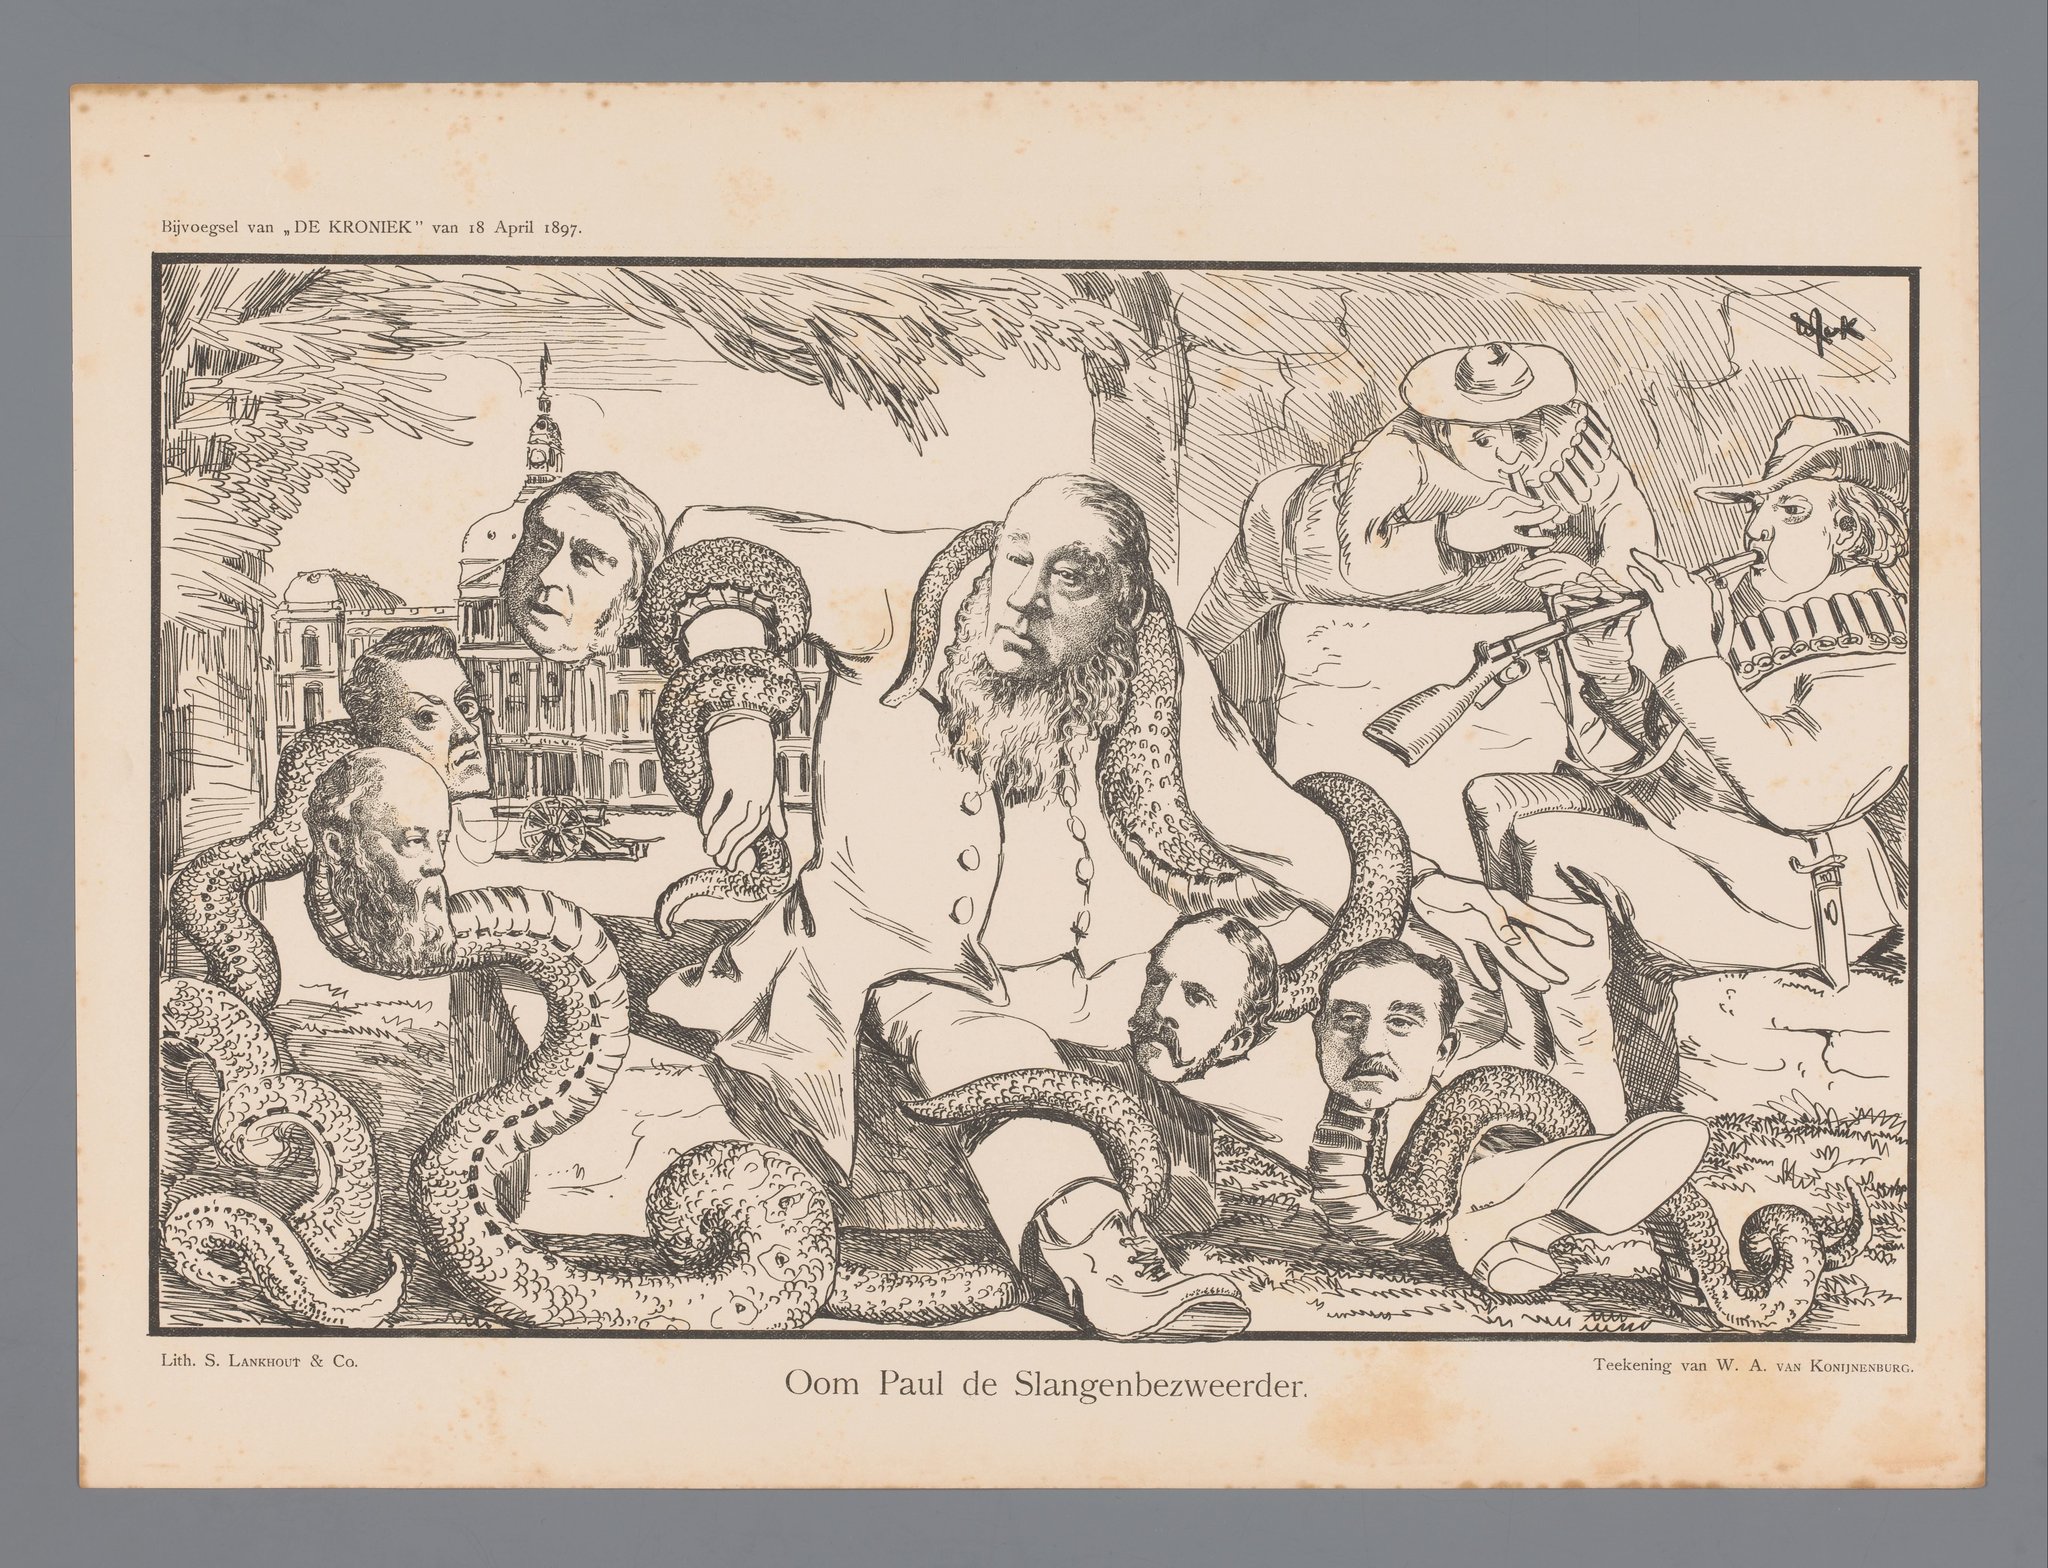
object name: print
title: Oom Paul de Slangenbezweerder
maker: willem van konijnenburg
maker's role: draughtsman, painter, print maker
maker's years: 1868-1943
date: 1897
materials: paper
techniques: lithograph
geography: the hague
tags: politician, monsters ~ snakes, political caricatures and satires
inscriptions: date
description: Prent uit het bijvoegsel van: De Kroniek 3 (1897), 18 april 1897.